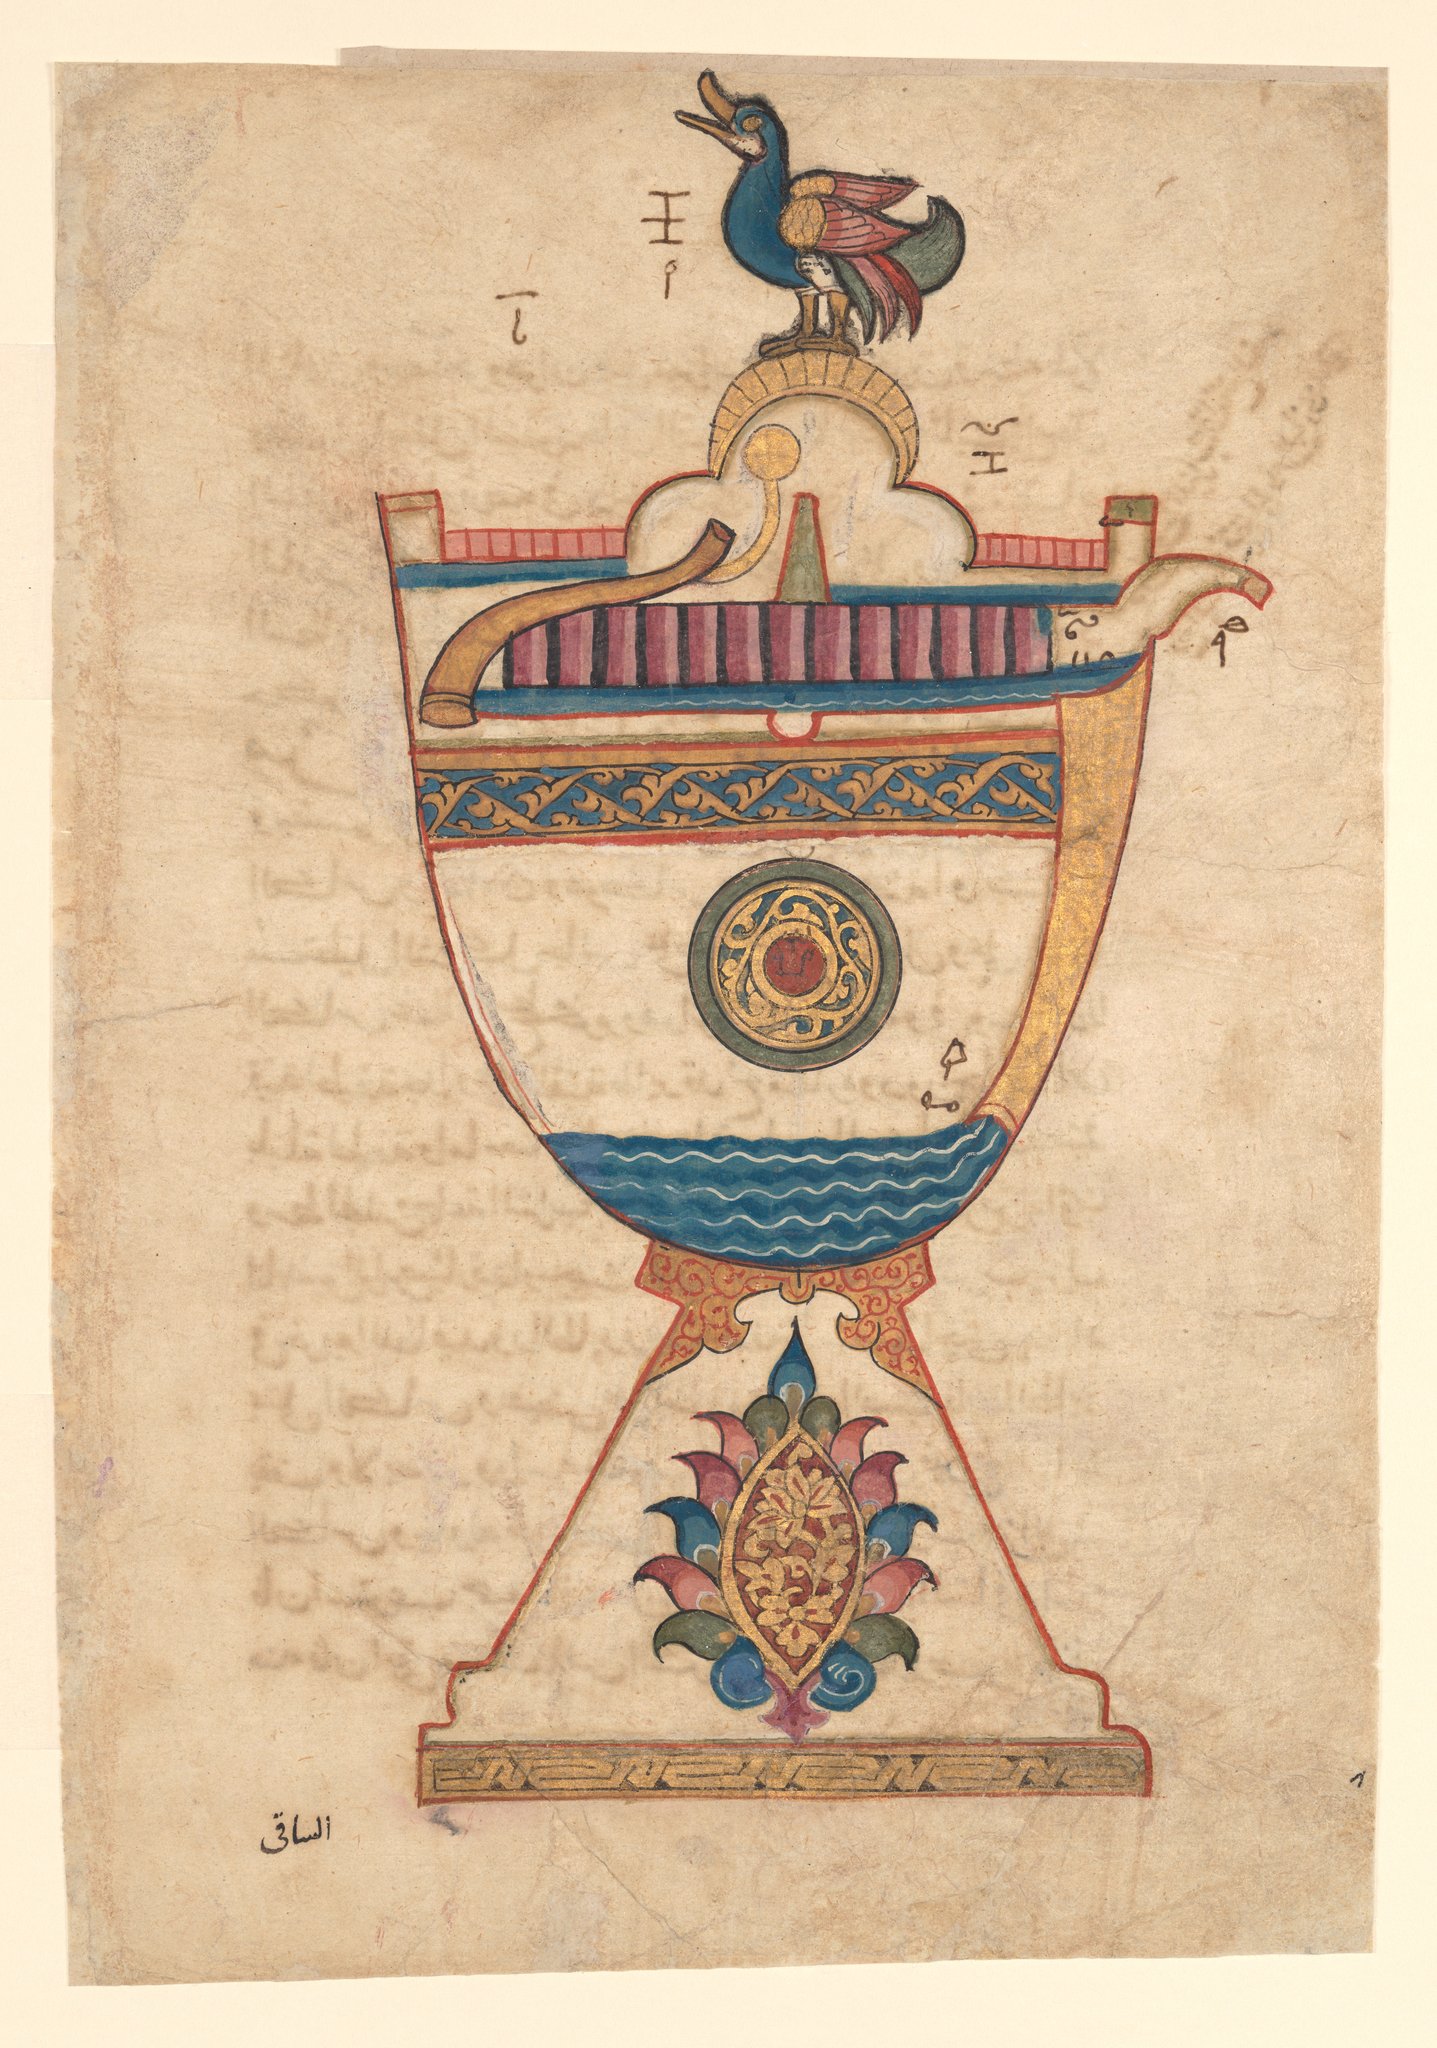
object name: folio from an illustrated manuscript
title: "Design for a Cup to Serve Wine at Drinking Parties", Folio from a Book of the Knowledge of Ingenious Mechanical Devices by al-Jazari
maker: badi' al-zaman ibn al-razzaz al-jazari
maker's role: author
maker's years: 1136-1206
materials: gold, ink, paper, watercolor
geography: syria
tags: birds,cups